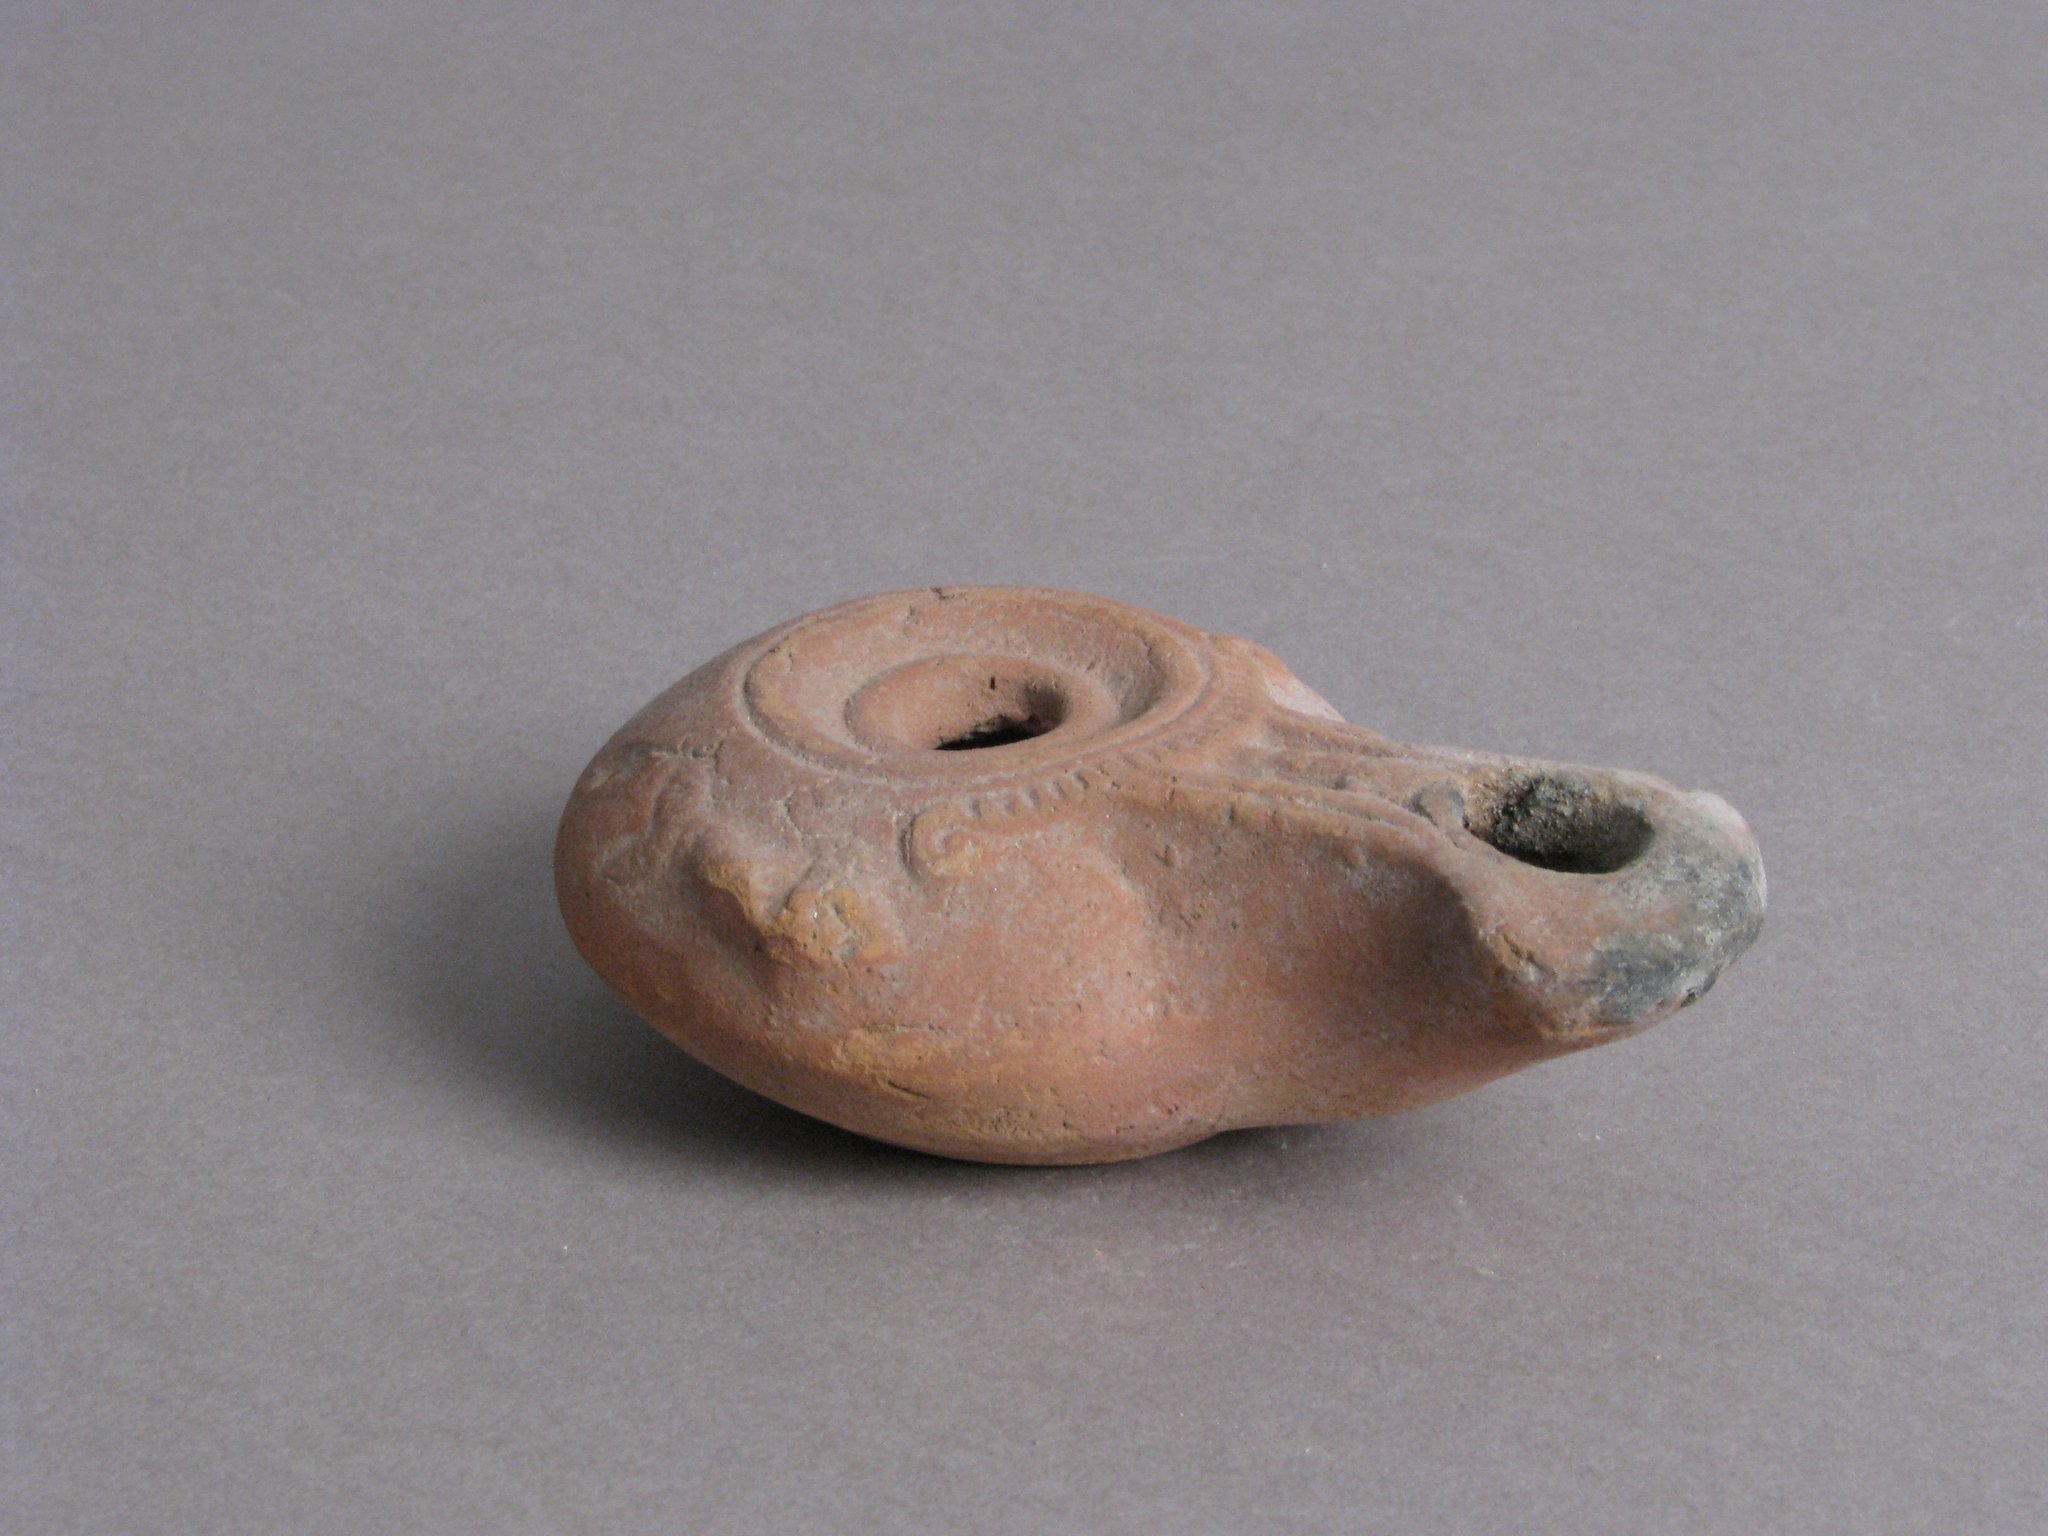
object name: lamp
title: Oil Lamp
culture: coptic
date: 301-700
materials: earthenware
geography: egypt